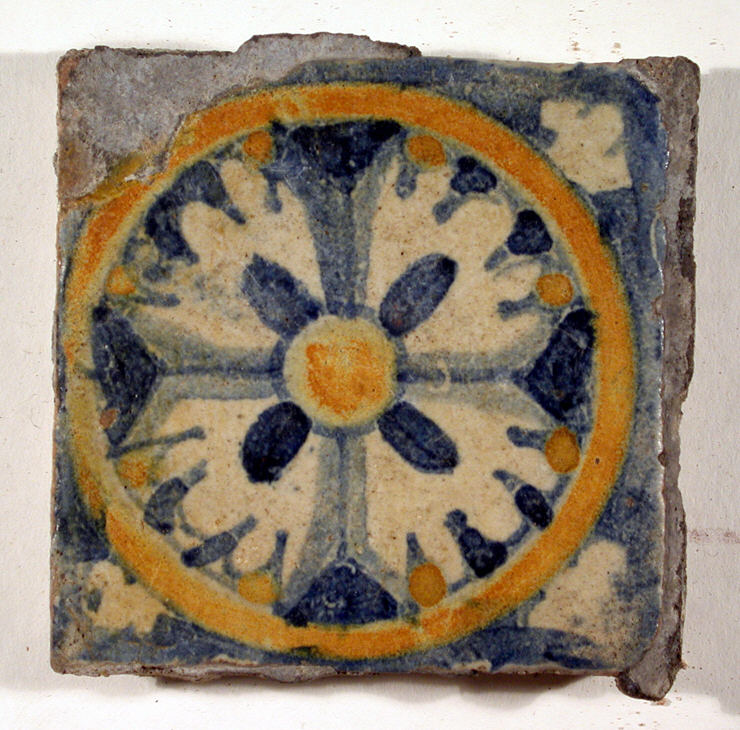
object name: pavement tile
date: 1501-1700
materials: earthenware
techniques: glazing